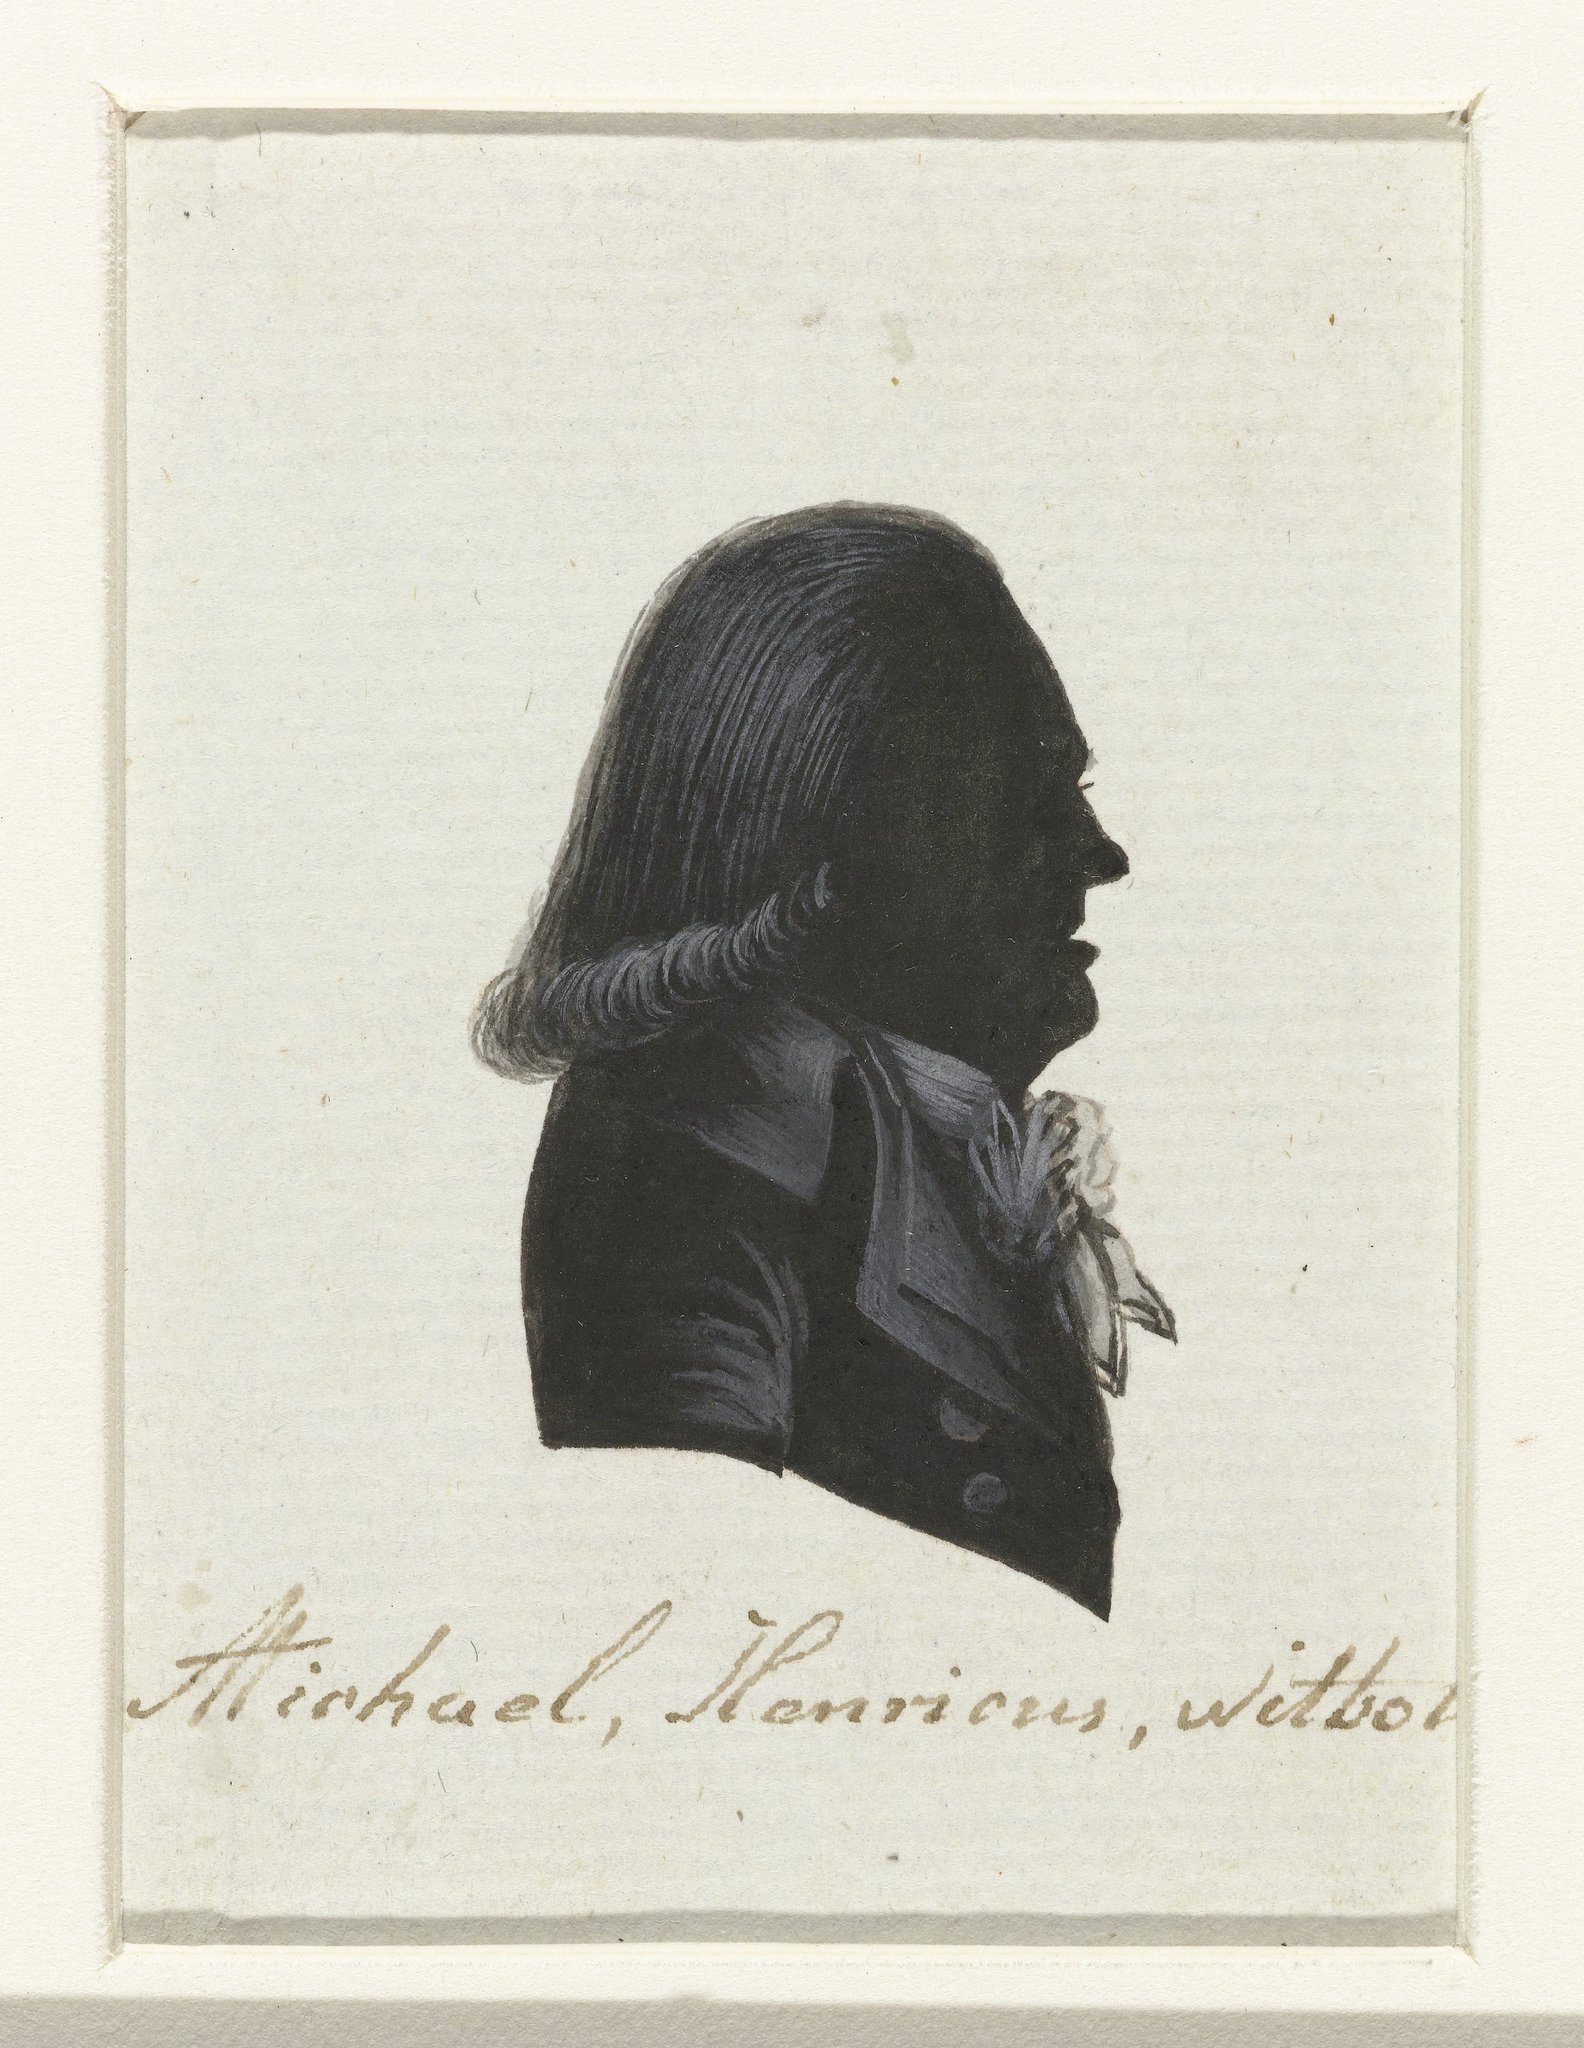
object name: silhouette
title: Representanten van de eerste Nationale Vergadering van de Bataafse Republiek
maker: hausdorff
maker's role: draughtsman, print maker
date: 1796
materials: ink, paper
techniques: drawing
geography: netherlands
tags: rotterdam, historical persons (+ profile portrait), the hague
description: Borstbeeld in profiel naar rechts. Tot op de schouders hangend, aan de onderzijde opgekruld haar. Gestrikte das. Opschrift; o.: Michael Henricus Witbols.